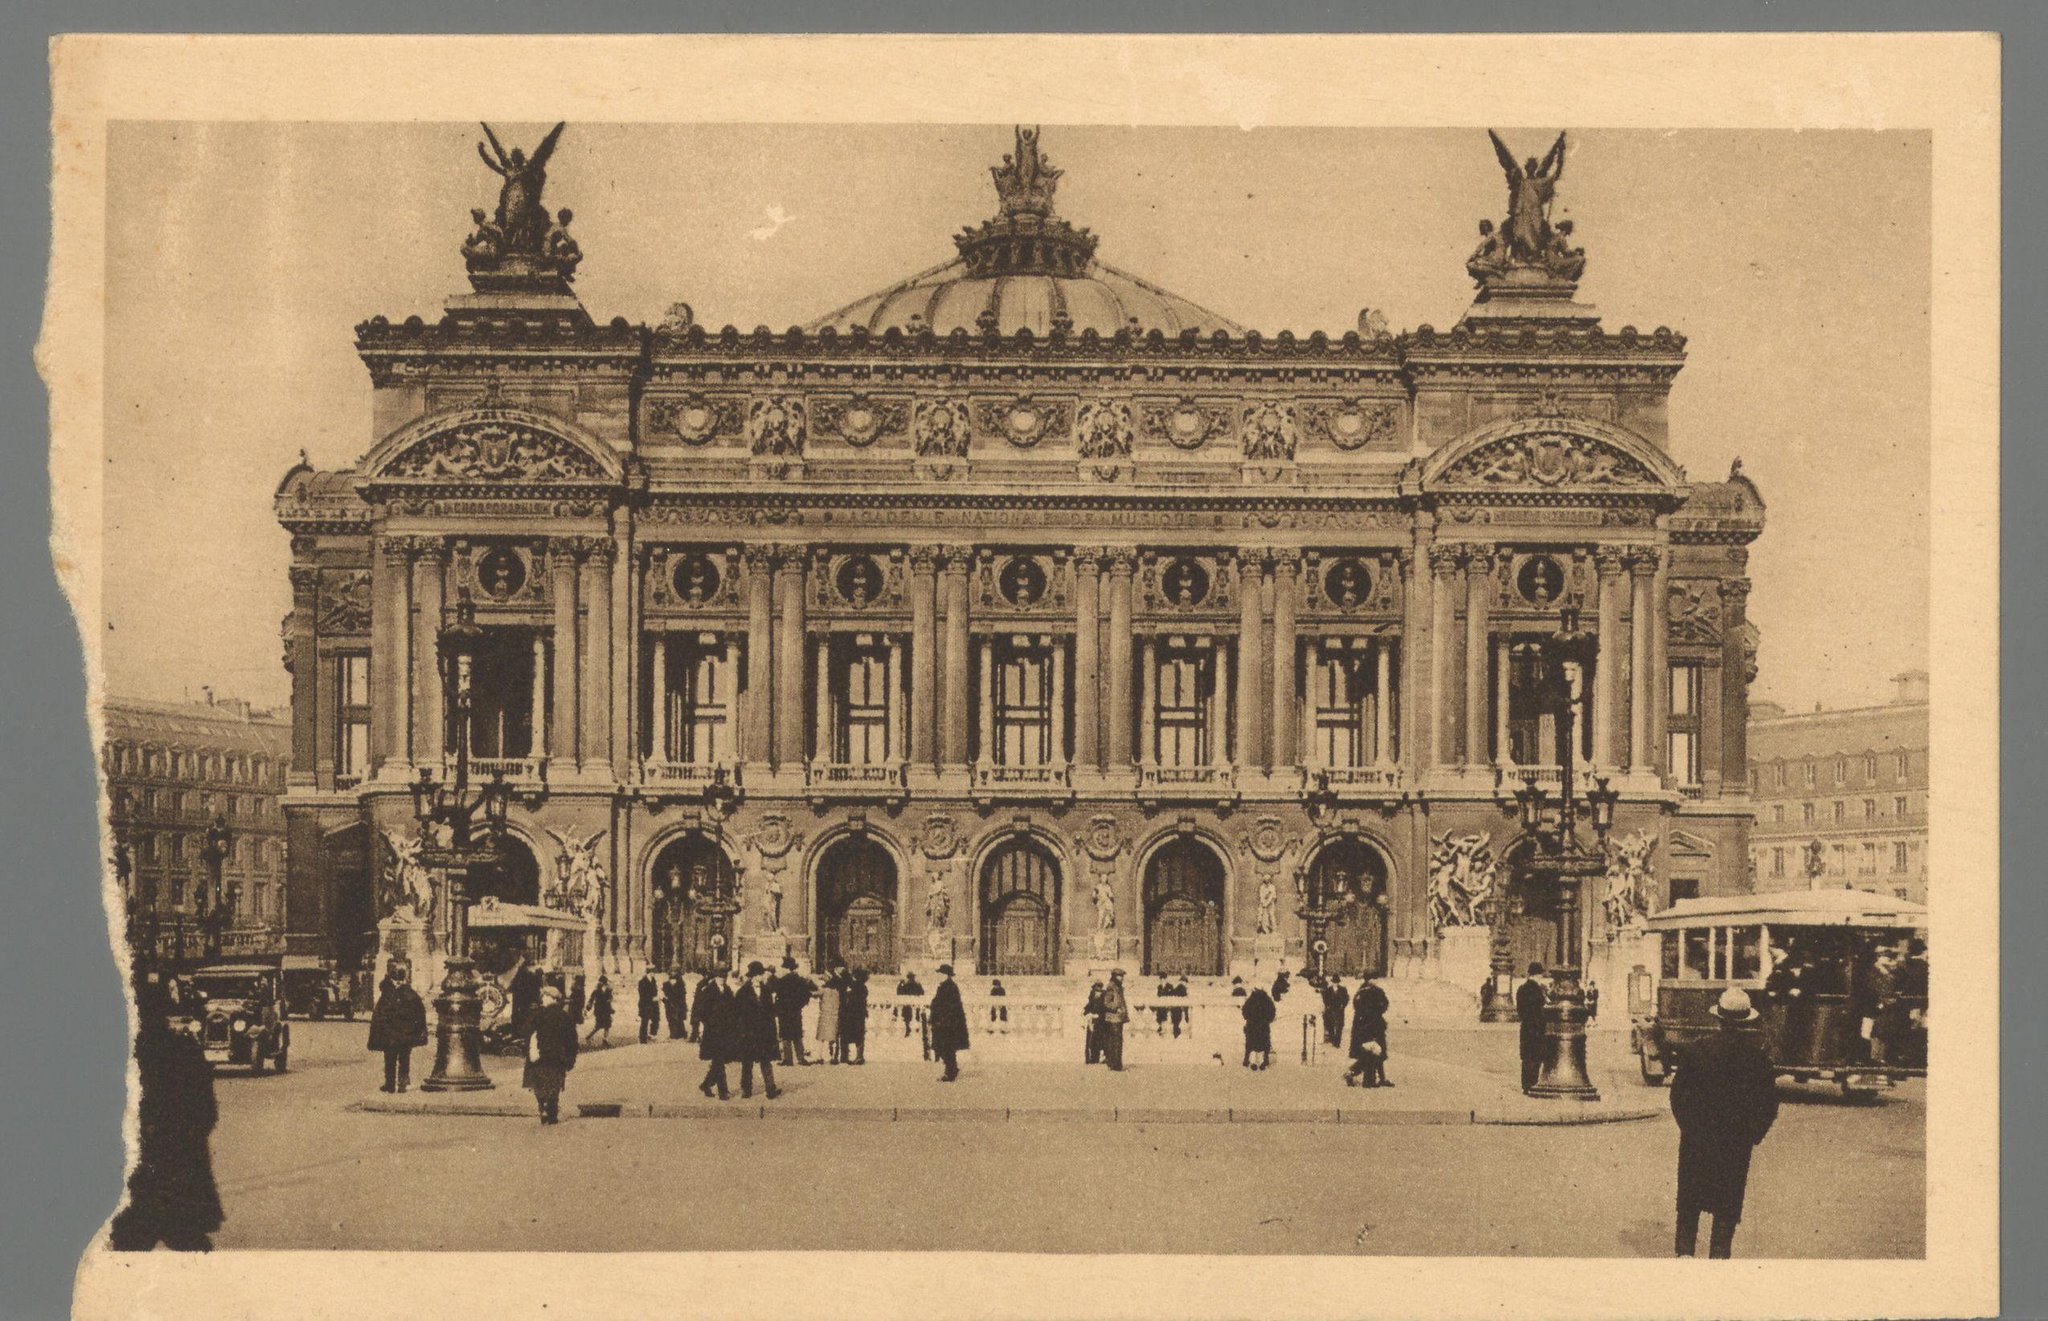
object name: photomechanical print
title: Paris. Opéra / The Opera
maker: Anonymous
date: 1903-1930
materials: cardboard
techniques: rotogravure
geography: paris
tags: opera house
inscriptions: collector's mark: ‘AFE v S’